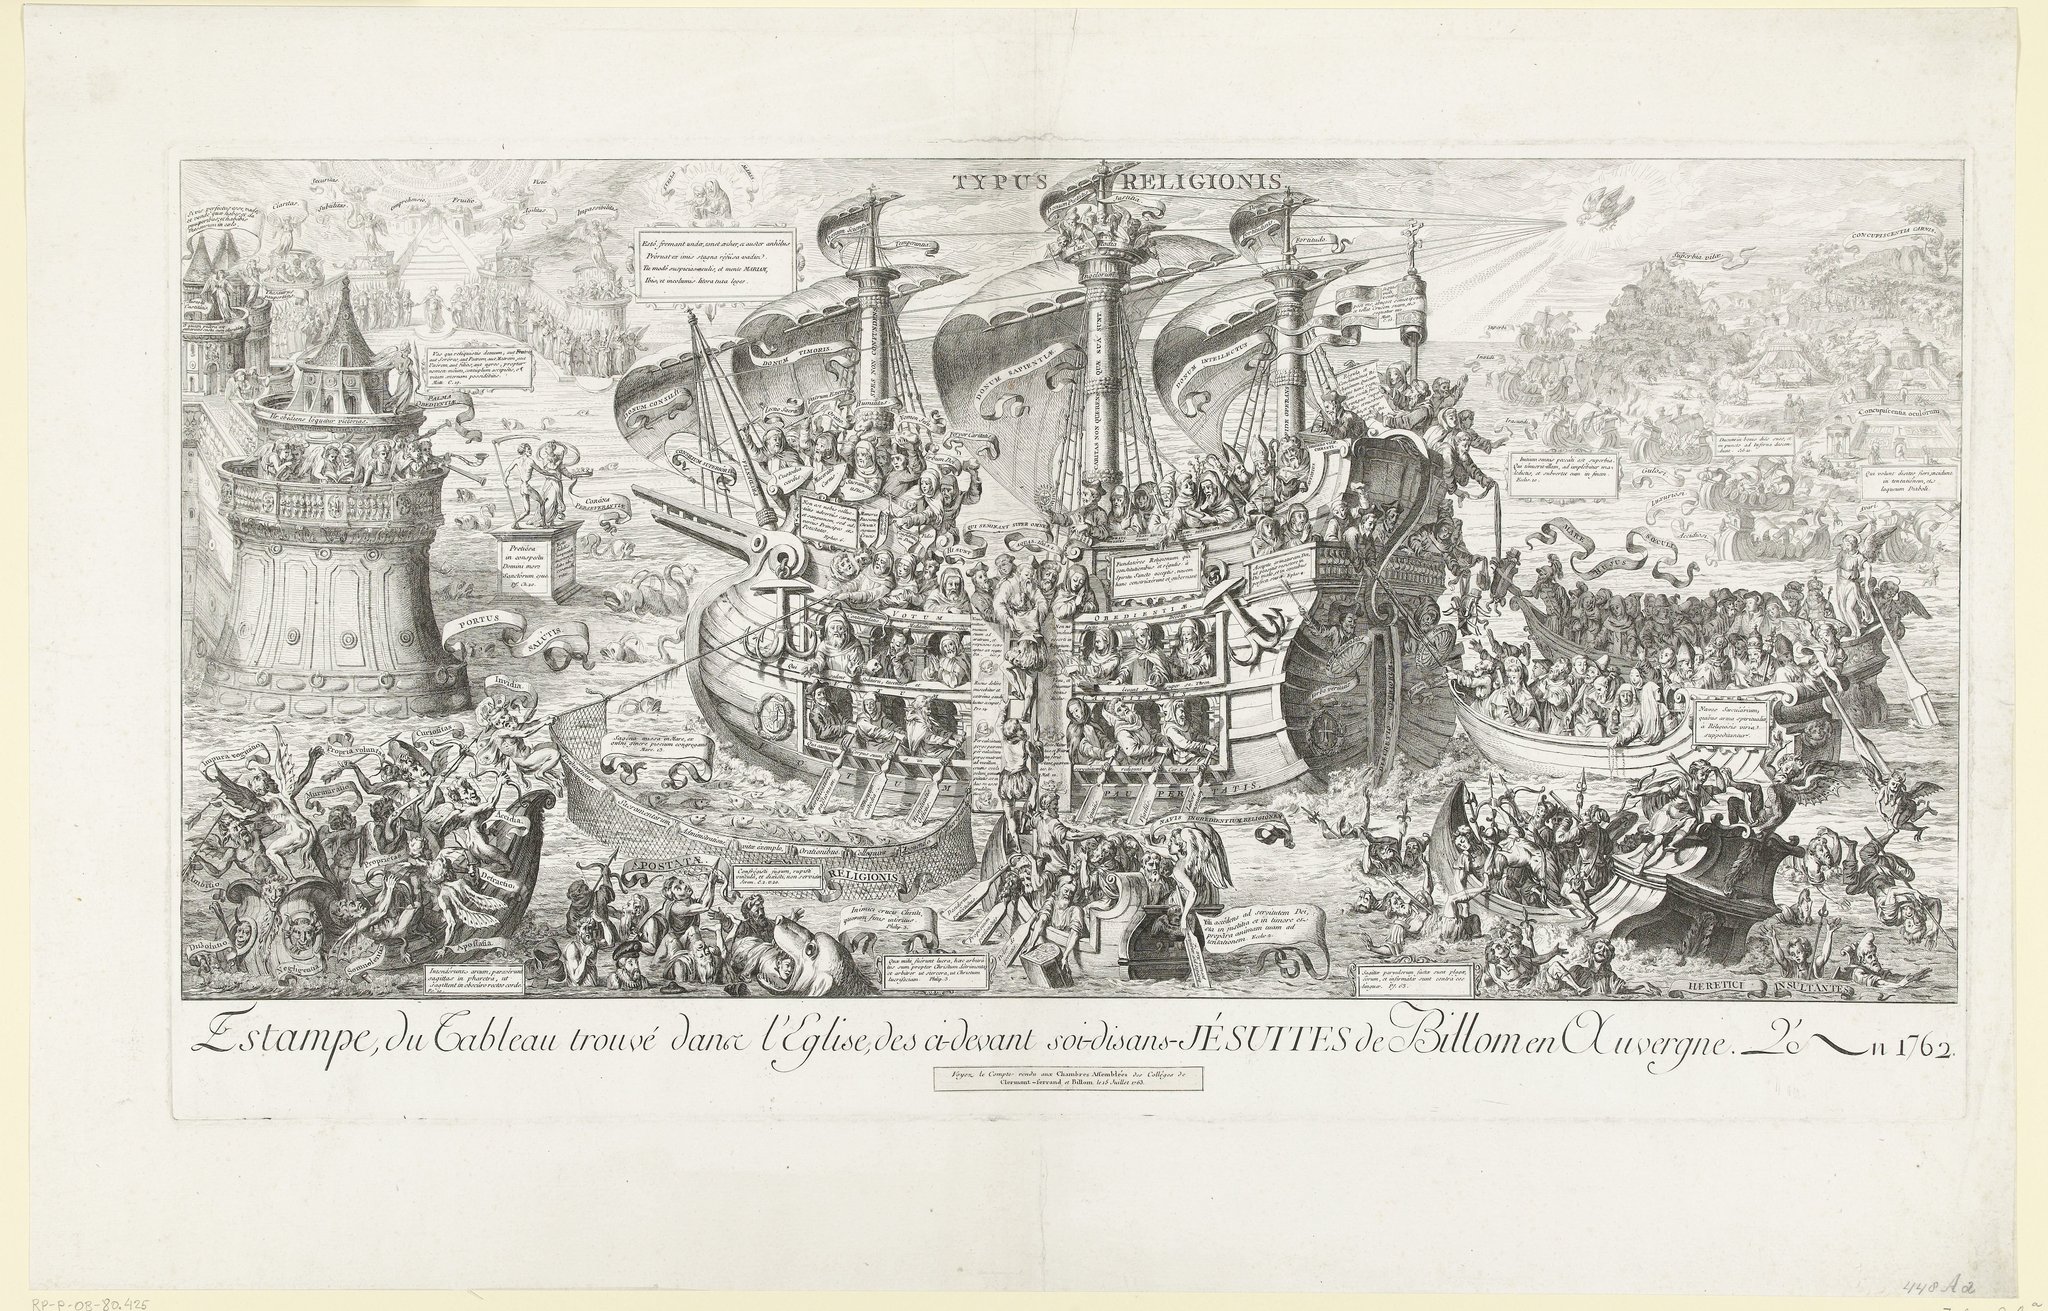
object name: print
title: Typus religionis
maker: Anonymous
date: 1762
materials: paper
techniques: etching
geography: france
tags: human life represented by a ship, ships (in general), (aspects of) christian religion or the church (as institution) ridiculed, criticized, or caricaturized, journey to heaven, pathway to heaven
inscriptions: date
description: Het schip van de strijdbare katholieke kerk. Zeilschip die de Roomse kerk voorstelt bemand door allerlei functionarissen en onderdelen van de katholieke kerk. In een sloep achter het schip zit de paus samen met de wereldse aanhangers van de kerk. Het schip wordt bedreigd vanuit bootjes bemand door ketters, afvalligen en zonden. Links het doel van de vaart: de haven der verlossing, de hemel. In de lucht stuwt de duif van de Heilige Geest het schip voort. Met vele opschriften in de voorstelling in het Frans en legenda A-E in het onderschrift. Volgens het onderschrift naar een schilderij in een kerk van de jezuïeten in Billom in de Auvergne, 1762. Allegorische spotprent op de hervorming, thematiek van ca. 1560.